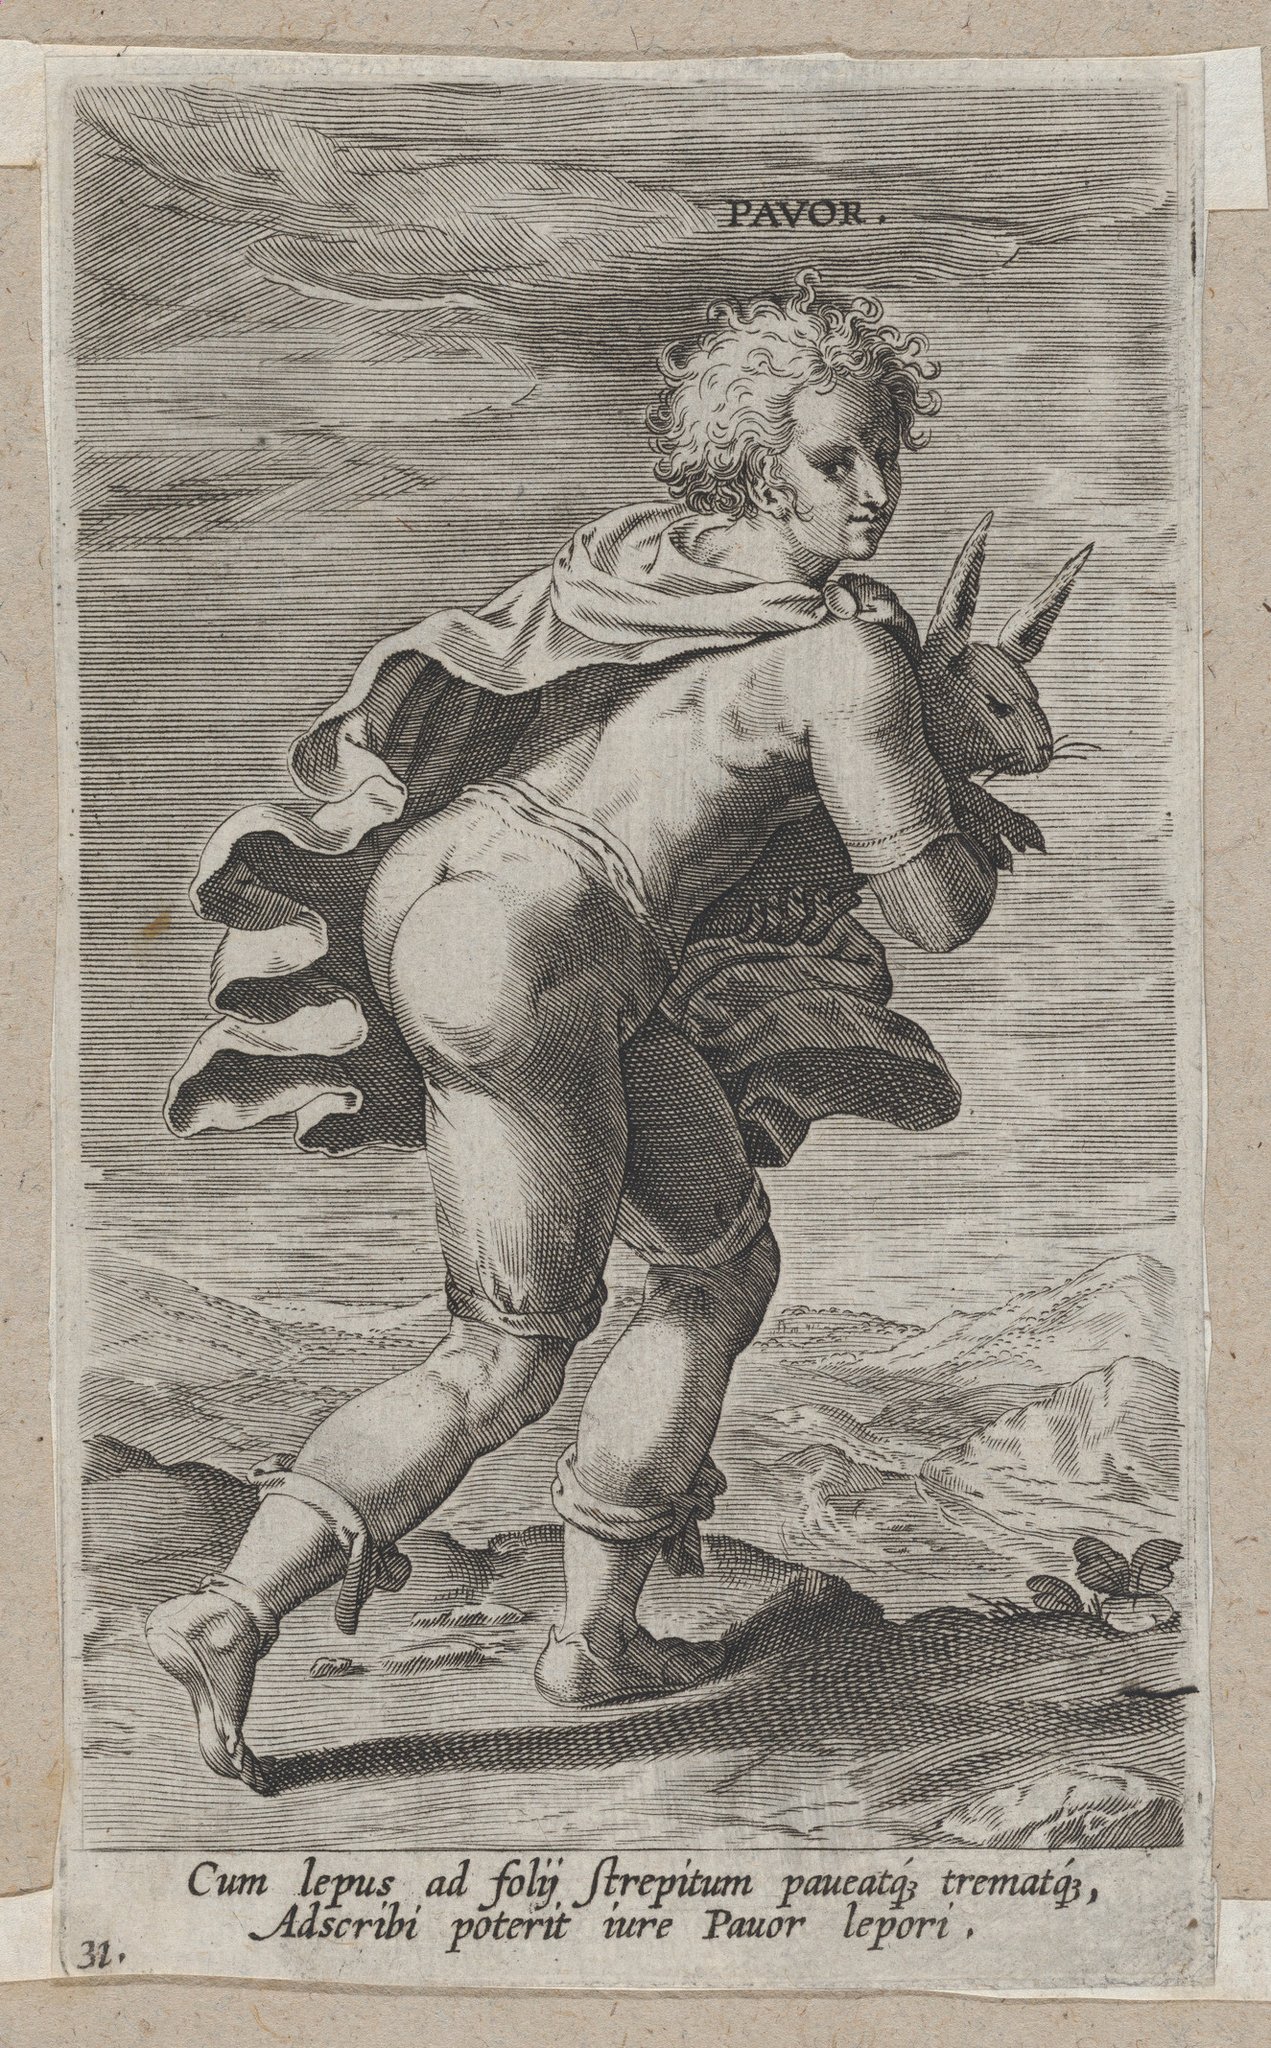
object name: print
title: Pavor, from "Proposopographia"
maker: philips galle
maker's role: artist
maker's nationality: netherlandish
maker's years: 1537-1612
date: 1585-1590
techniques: engraving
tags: animals,male nudes